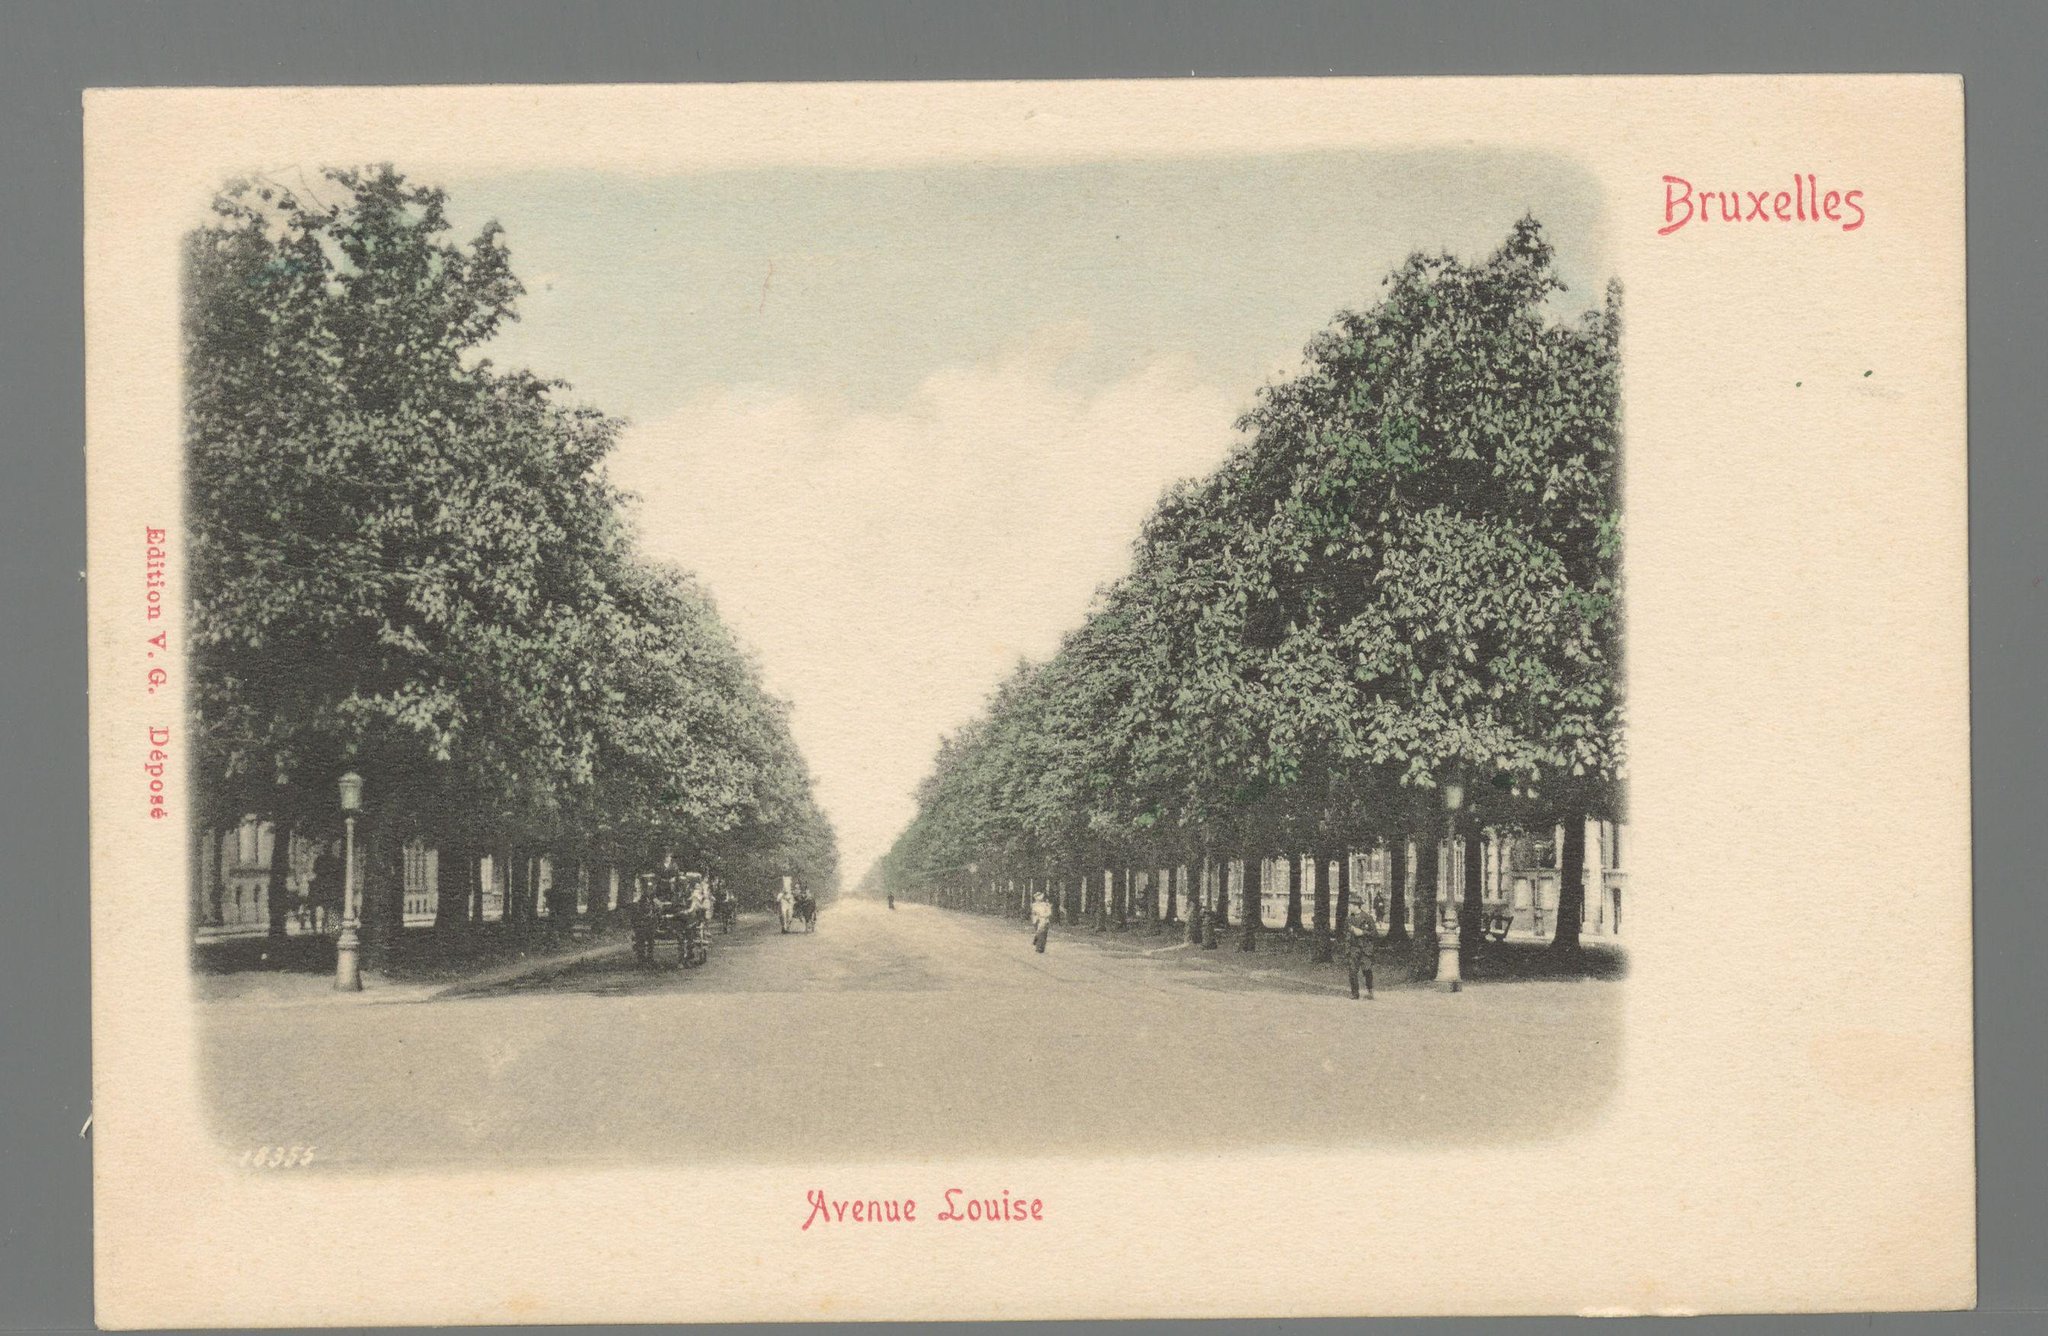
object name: ansichtkaart, prentbriefkaart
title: Bruxelles. Avenue Louise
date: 1897-1906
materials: cardboard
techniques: photograph, hand coloring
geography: brussels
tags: trees, avenue, boulevard, promenade, esplanade, brussels